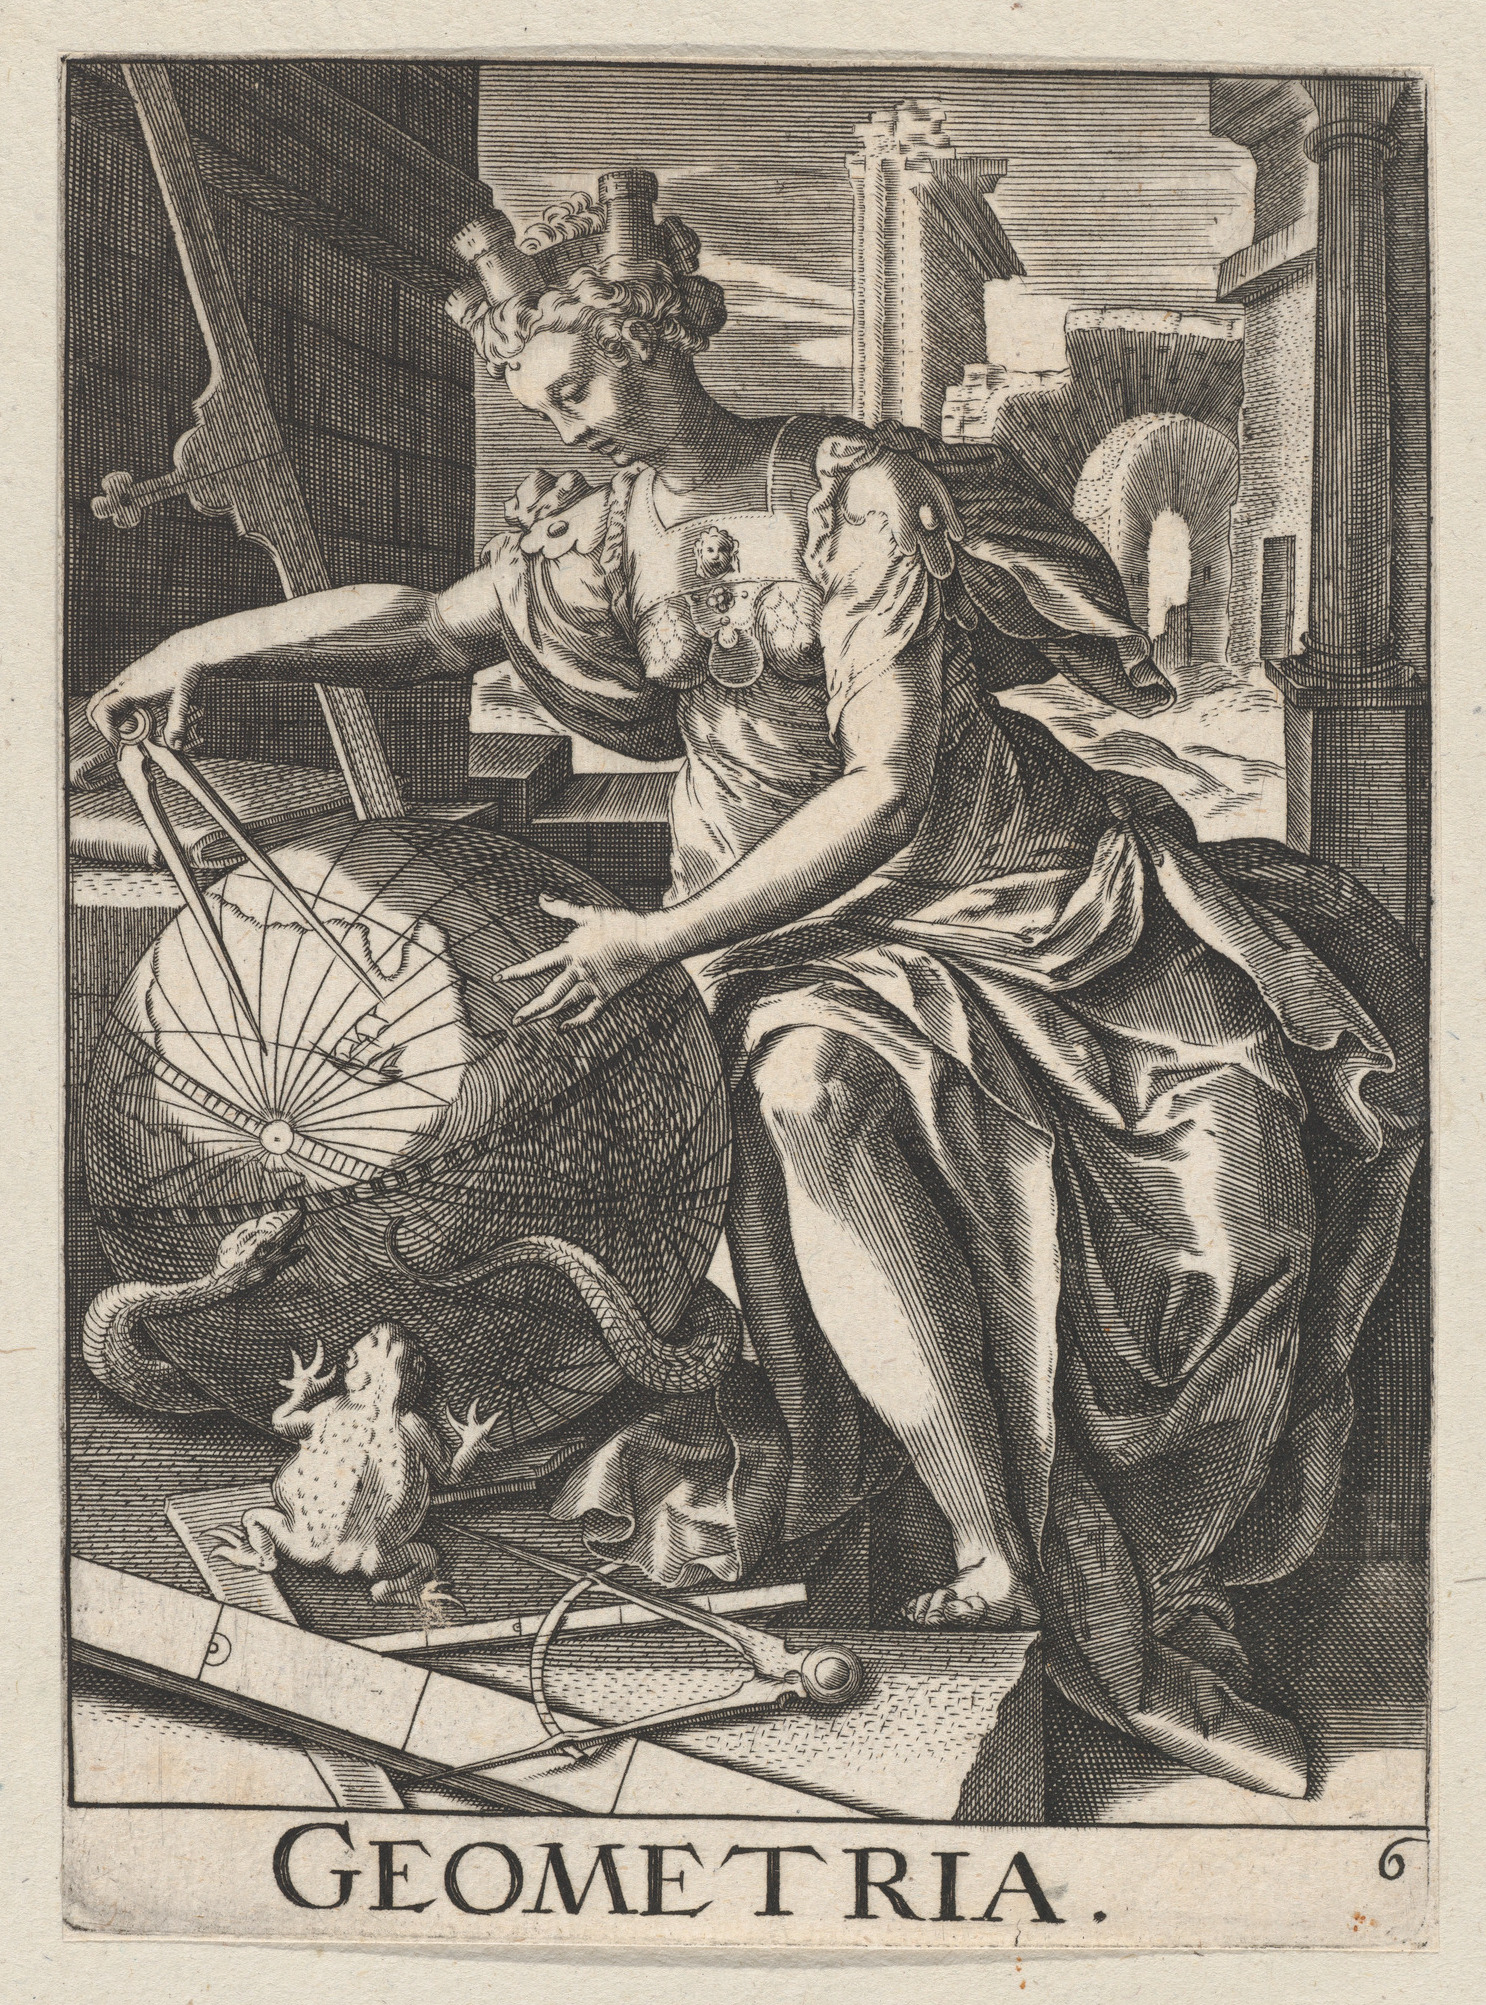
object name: print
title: Geometria, plate 6 from "The Seven Liberal Arts"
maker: paulus fürst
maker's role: artist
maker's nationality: german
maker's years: 1608-1666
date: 1628-1666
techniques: engraving, etching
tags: women,frogs,snakes,globes